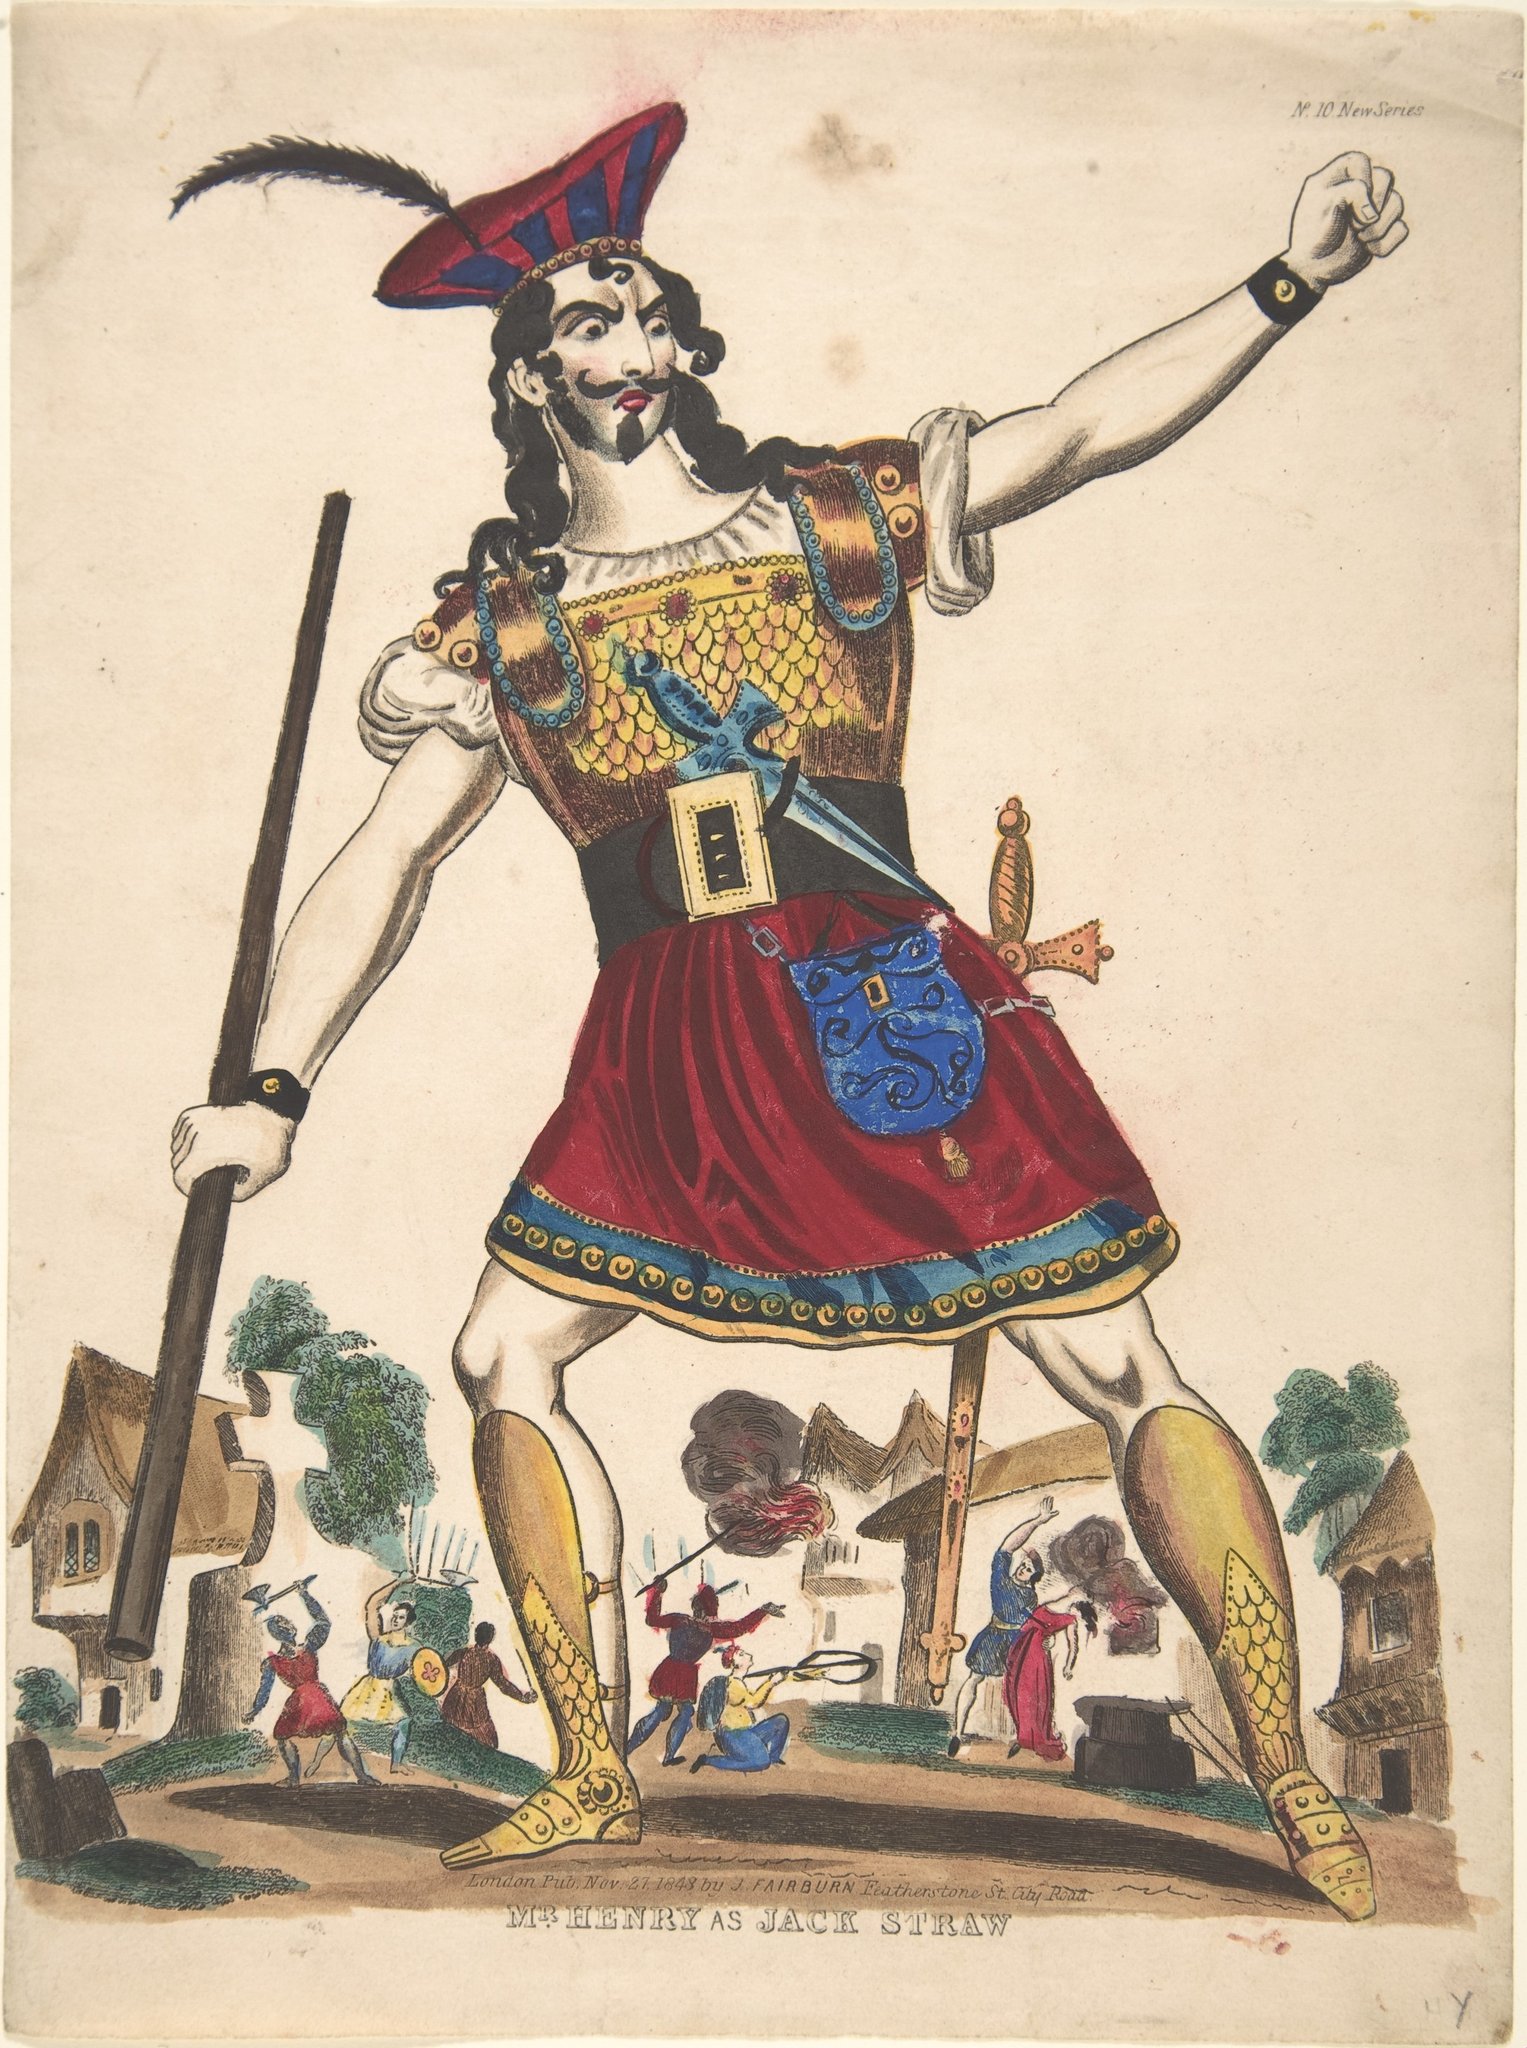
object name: print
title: Mr. Henry as Jack Straw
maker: anonymous, british, 19th century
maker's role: artist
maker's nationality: british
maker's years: 1800-1900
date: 1848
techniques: etching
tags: soldiers